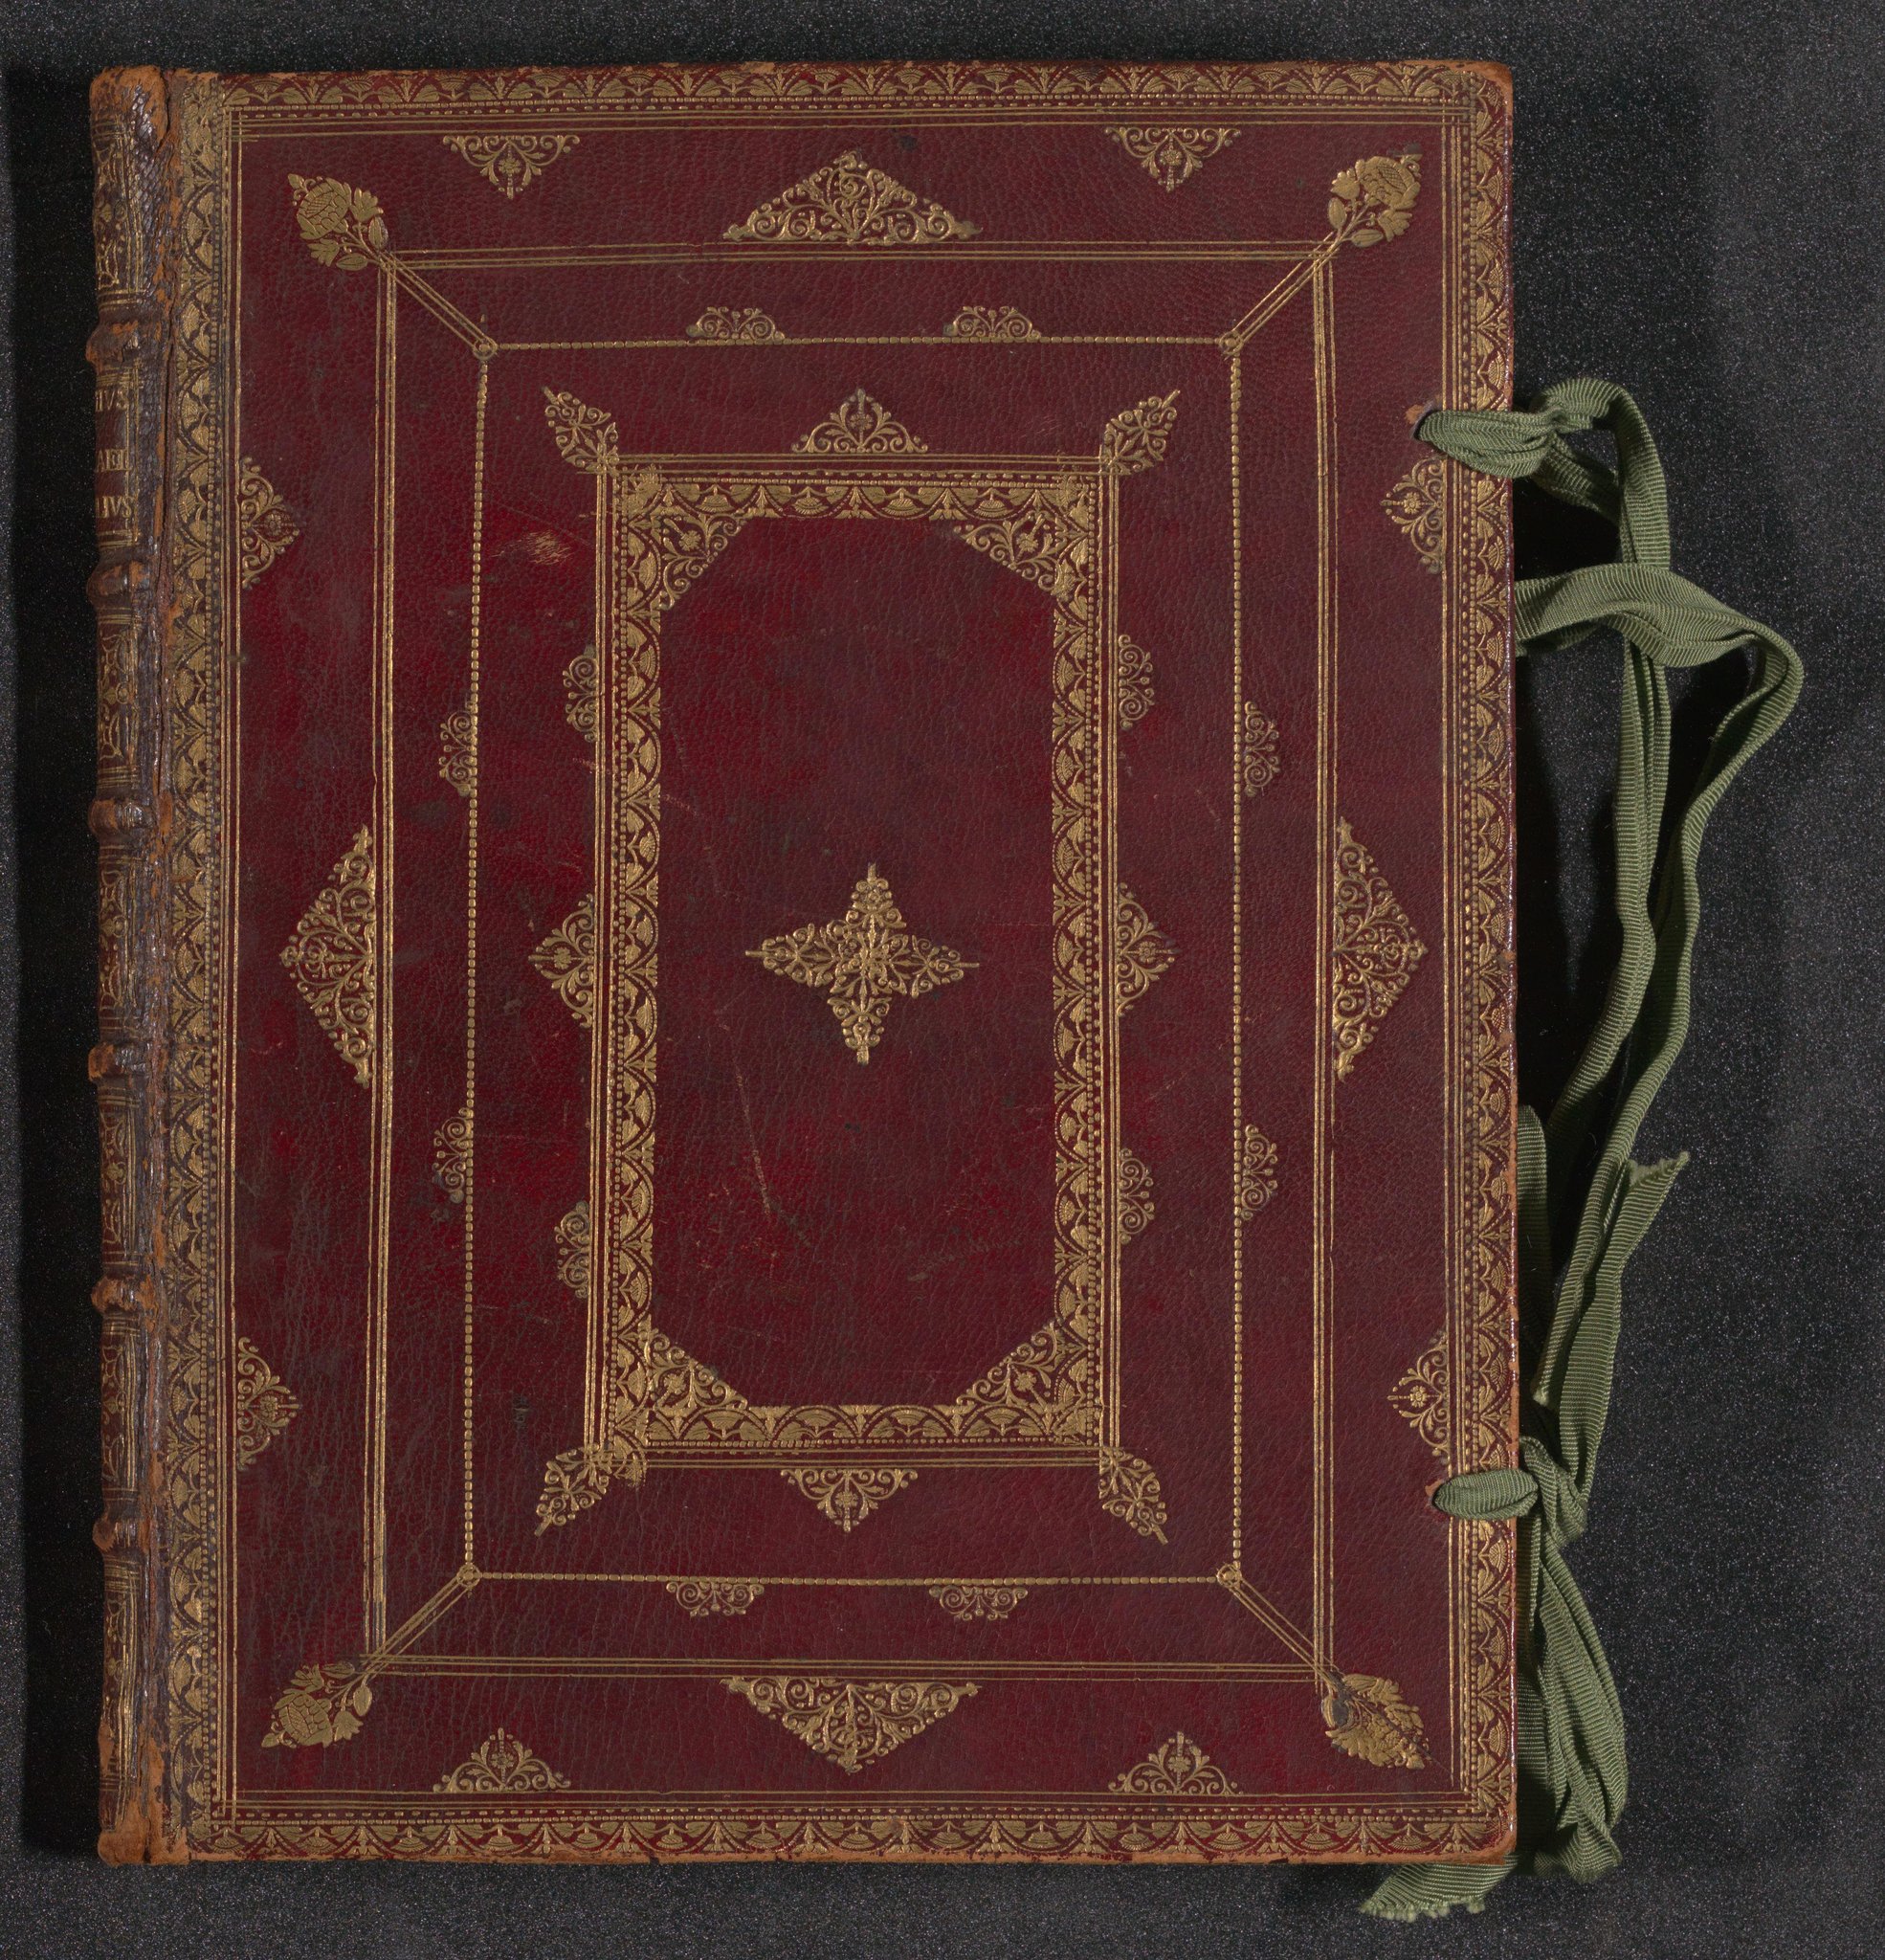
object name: prentrecueil, prentenalbum, prentalbum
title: Statius of Michael Angelius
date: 1520-1612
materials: gold leaf, leather, paper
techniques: bookbinding, engraving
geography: italy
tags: the (nude) human figure; 'corpo humano' (ripa), sibyls, portrait, self-portrait of artist, haman on the gallows, fruits: acorn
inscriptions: collector's mark: Lugt 2166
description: Album met 77 albumbladen en 75 opgeplakte gravures. Het album bevat een serie bestaande uit een titelprent en 72 voorstellingen met figuren en figuurgroepen naar schilderingen door Michelangelo in de Sixtijnse Kapel in het Vaticaan. Na de titelprent volgt een portret van Michelangelo door Christoforo Blanco en na afloop van de serie volgt een prent door Cornelis Bos. Leren band gestempeld met bladgoud, beplakt met spiraalkammarmerpapier.